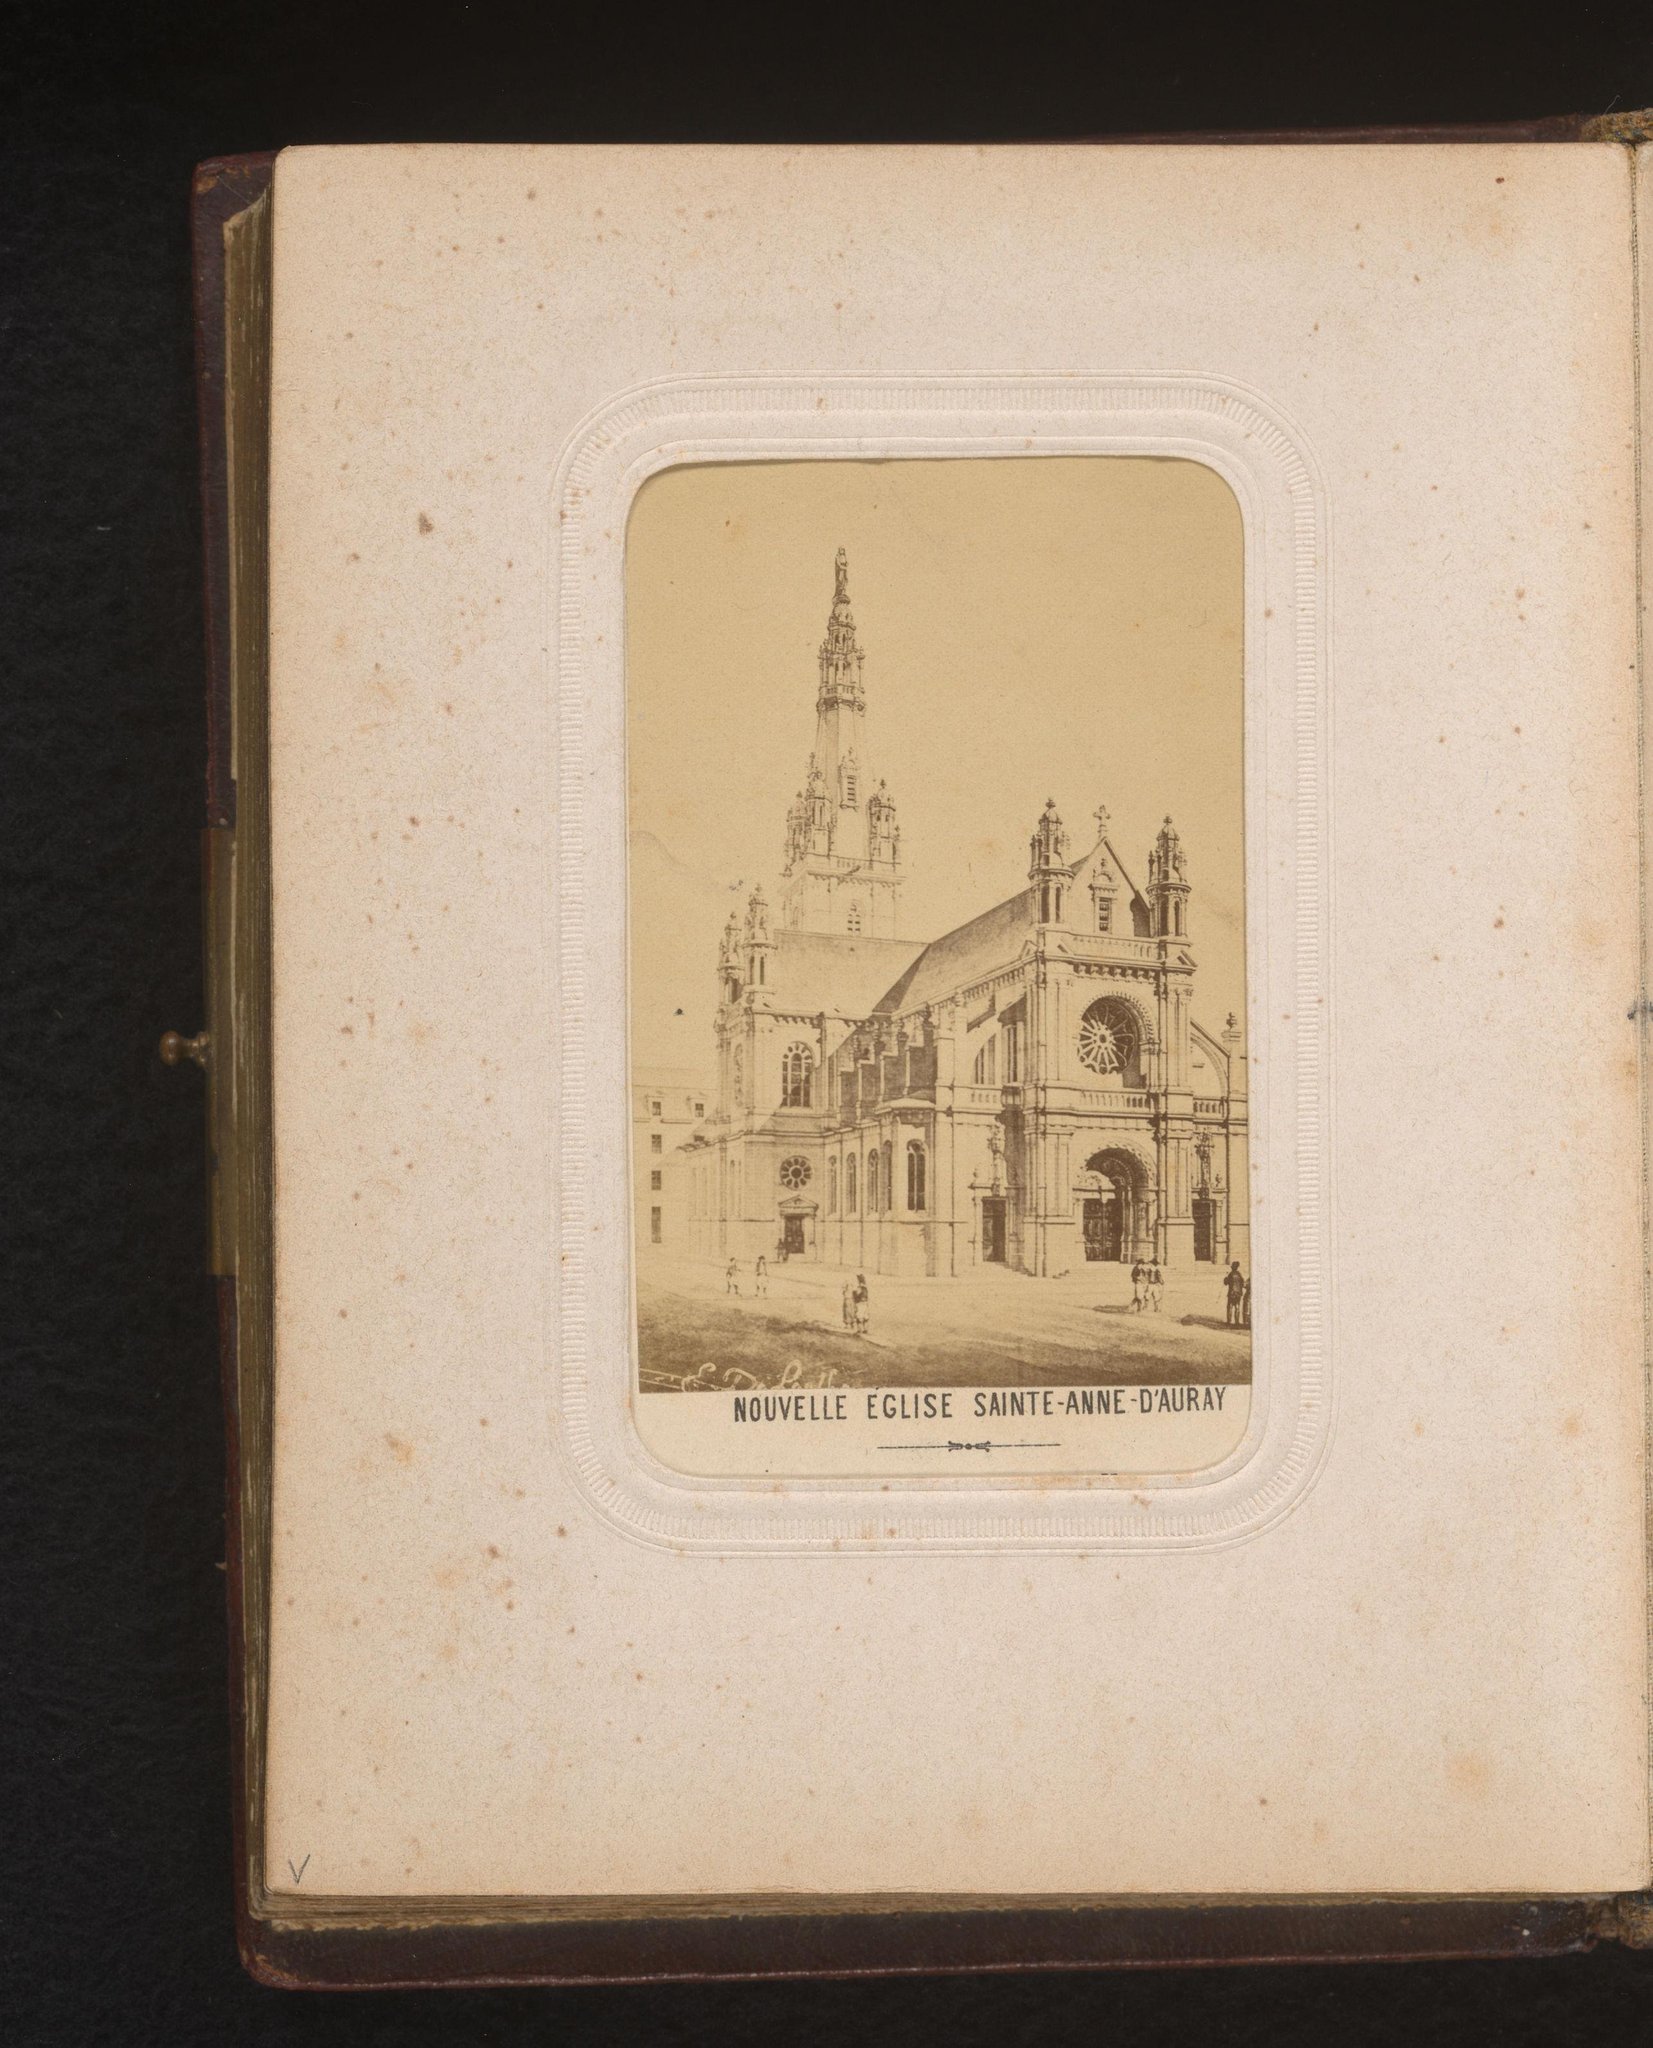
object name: album leaf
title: Fotoreproductie van een tekening van de Basilique Sainte-Anne in Sainte-Anne-d'Auray, Frankrijk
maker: Anonymous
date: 1860-1900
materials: cardboard, photographic support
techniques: albumen print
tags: church (exterior)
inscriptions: inscription: ‘E. de Perthes ARCHte’, inscription: ‘LITANIES DE SAINTE ANNE/ (...)/ Se vend UN franc/ du profit de la reconstruction de la Chapelle.’